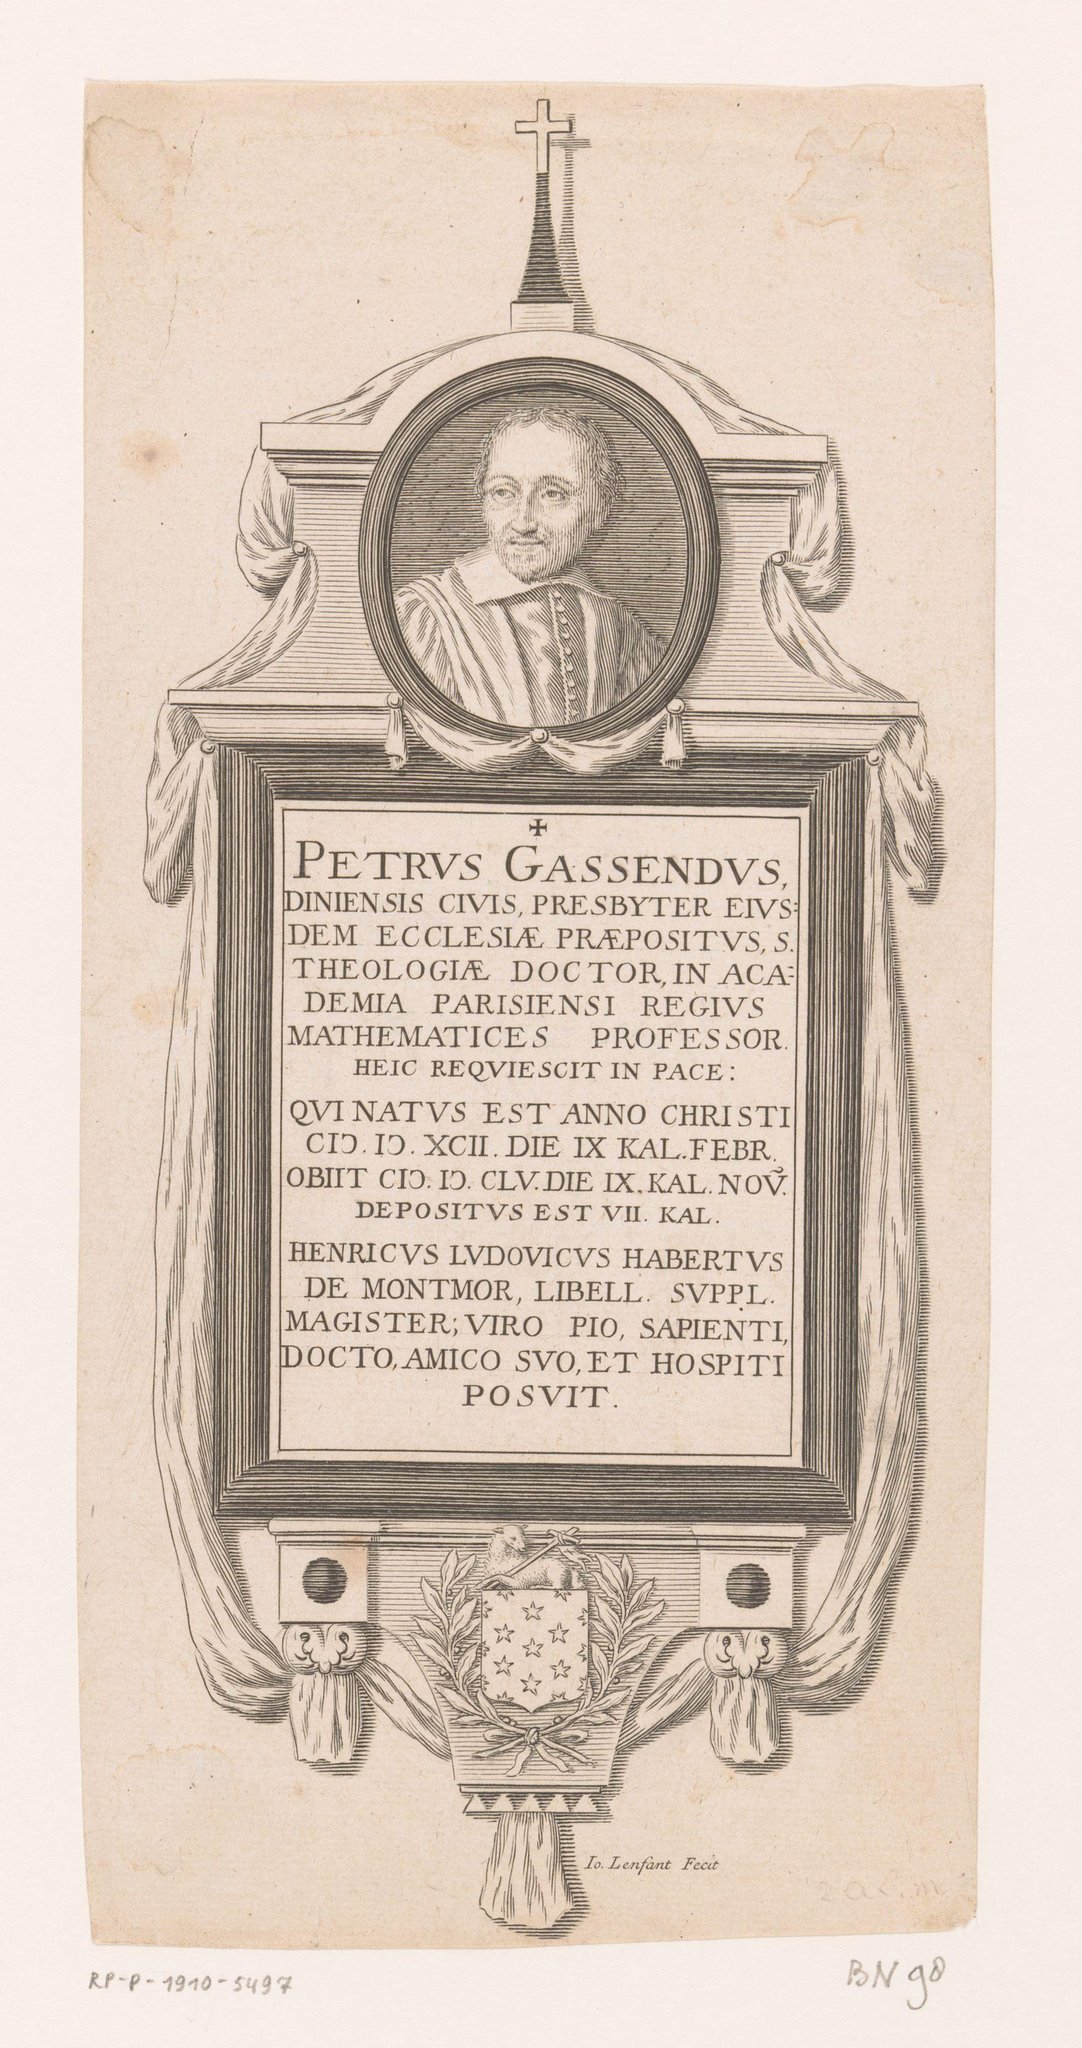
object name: print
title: Epitaaf met portret van Pierre Gassendi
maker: lenfant (a paris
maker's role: print maker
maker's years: 1615-1674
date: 1625-1674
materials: paper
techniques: engraving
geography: france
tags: paris, priest, scholar, philosopher, historical persons, epitaph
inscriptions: collector's mark: Lugt 2228